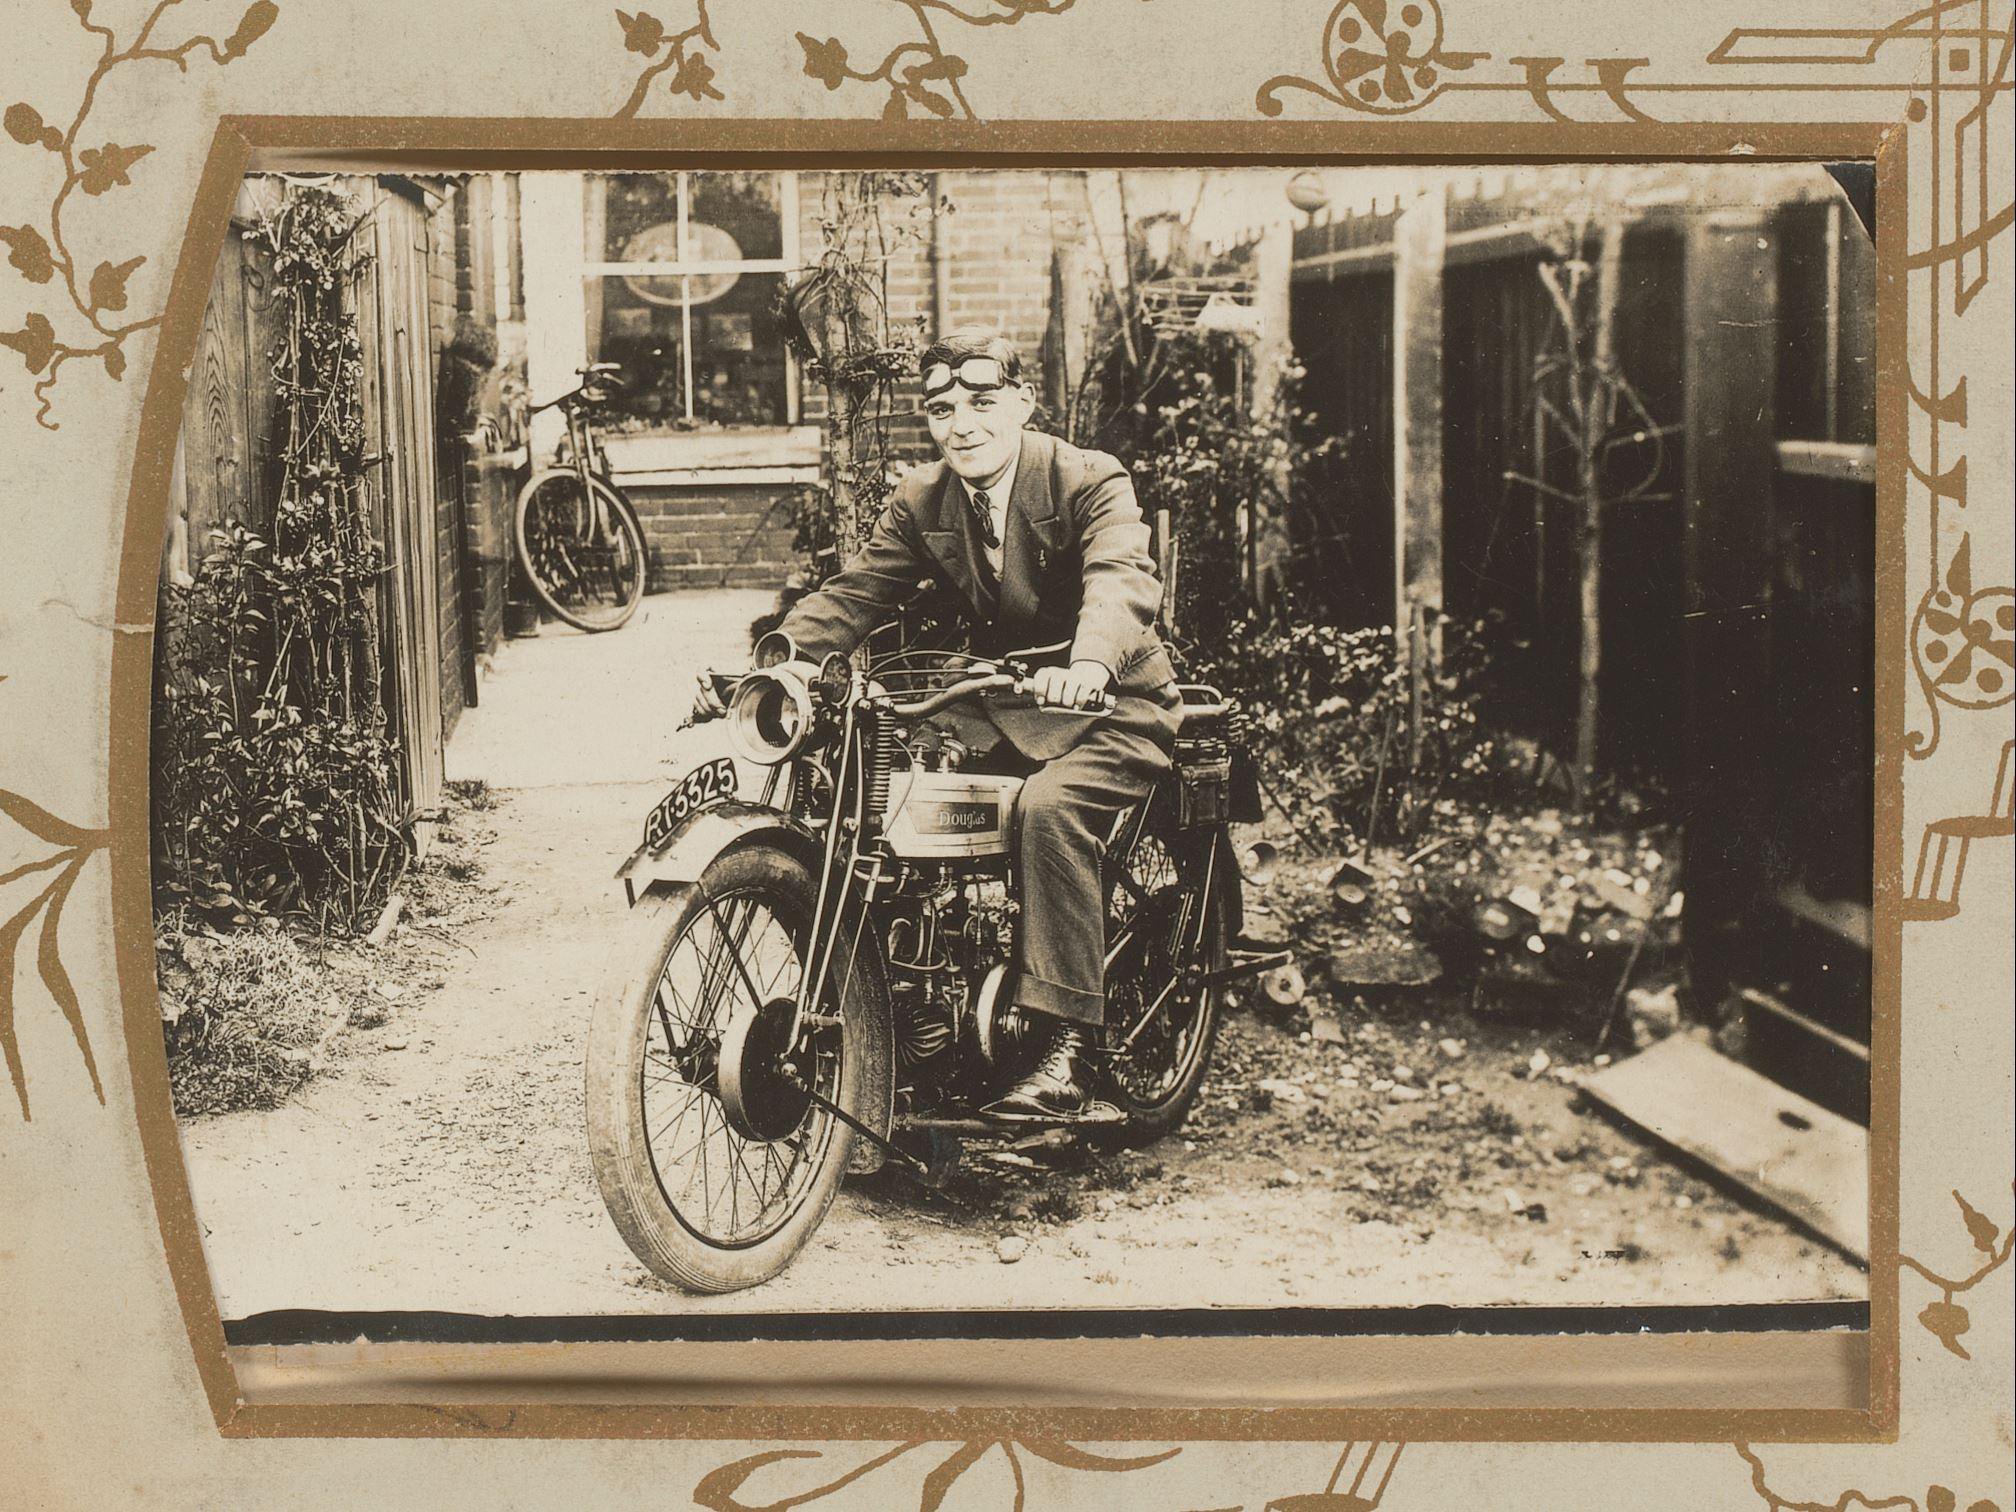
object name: photograph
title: Man op een motor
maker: Anonymous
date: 1899-1920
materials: photographic support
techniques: gelatin silver print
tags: motor-cycles and other two-wheeled motor-vehicles, adult man, historical persons